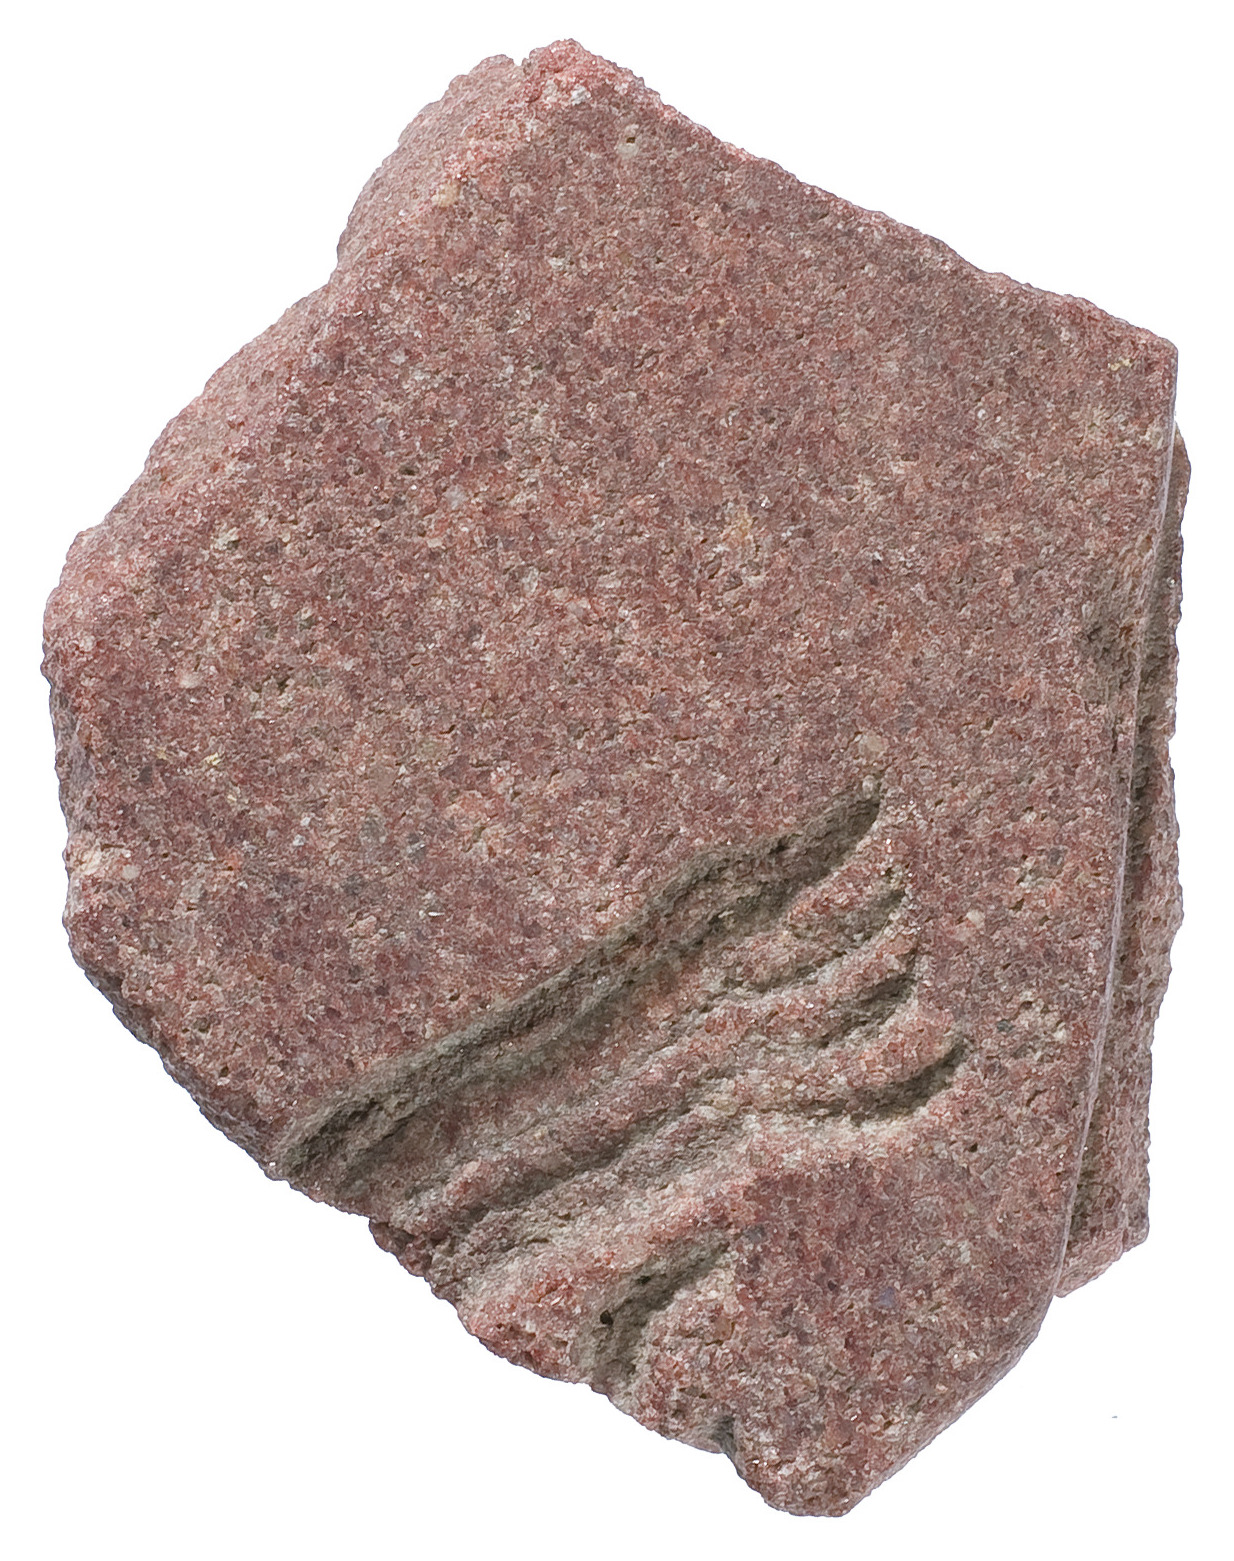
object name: hand, aten ray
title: Hand raised in worship adjacent to Aten ray (?)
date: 1353-1336 BCE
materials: quartzite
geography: egypt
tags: hands